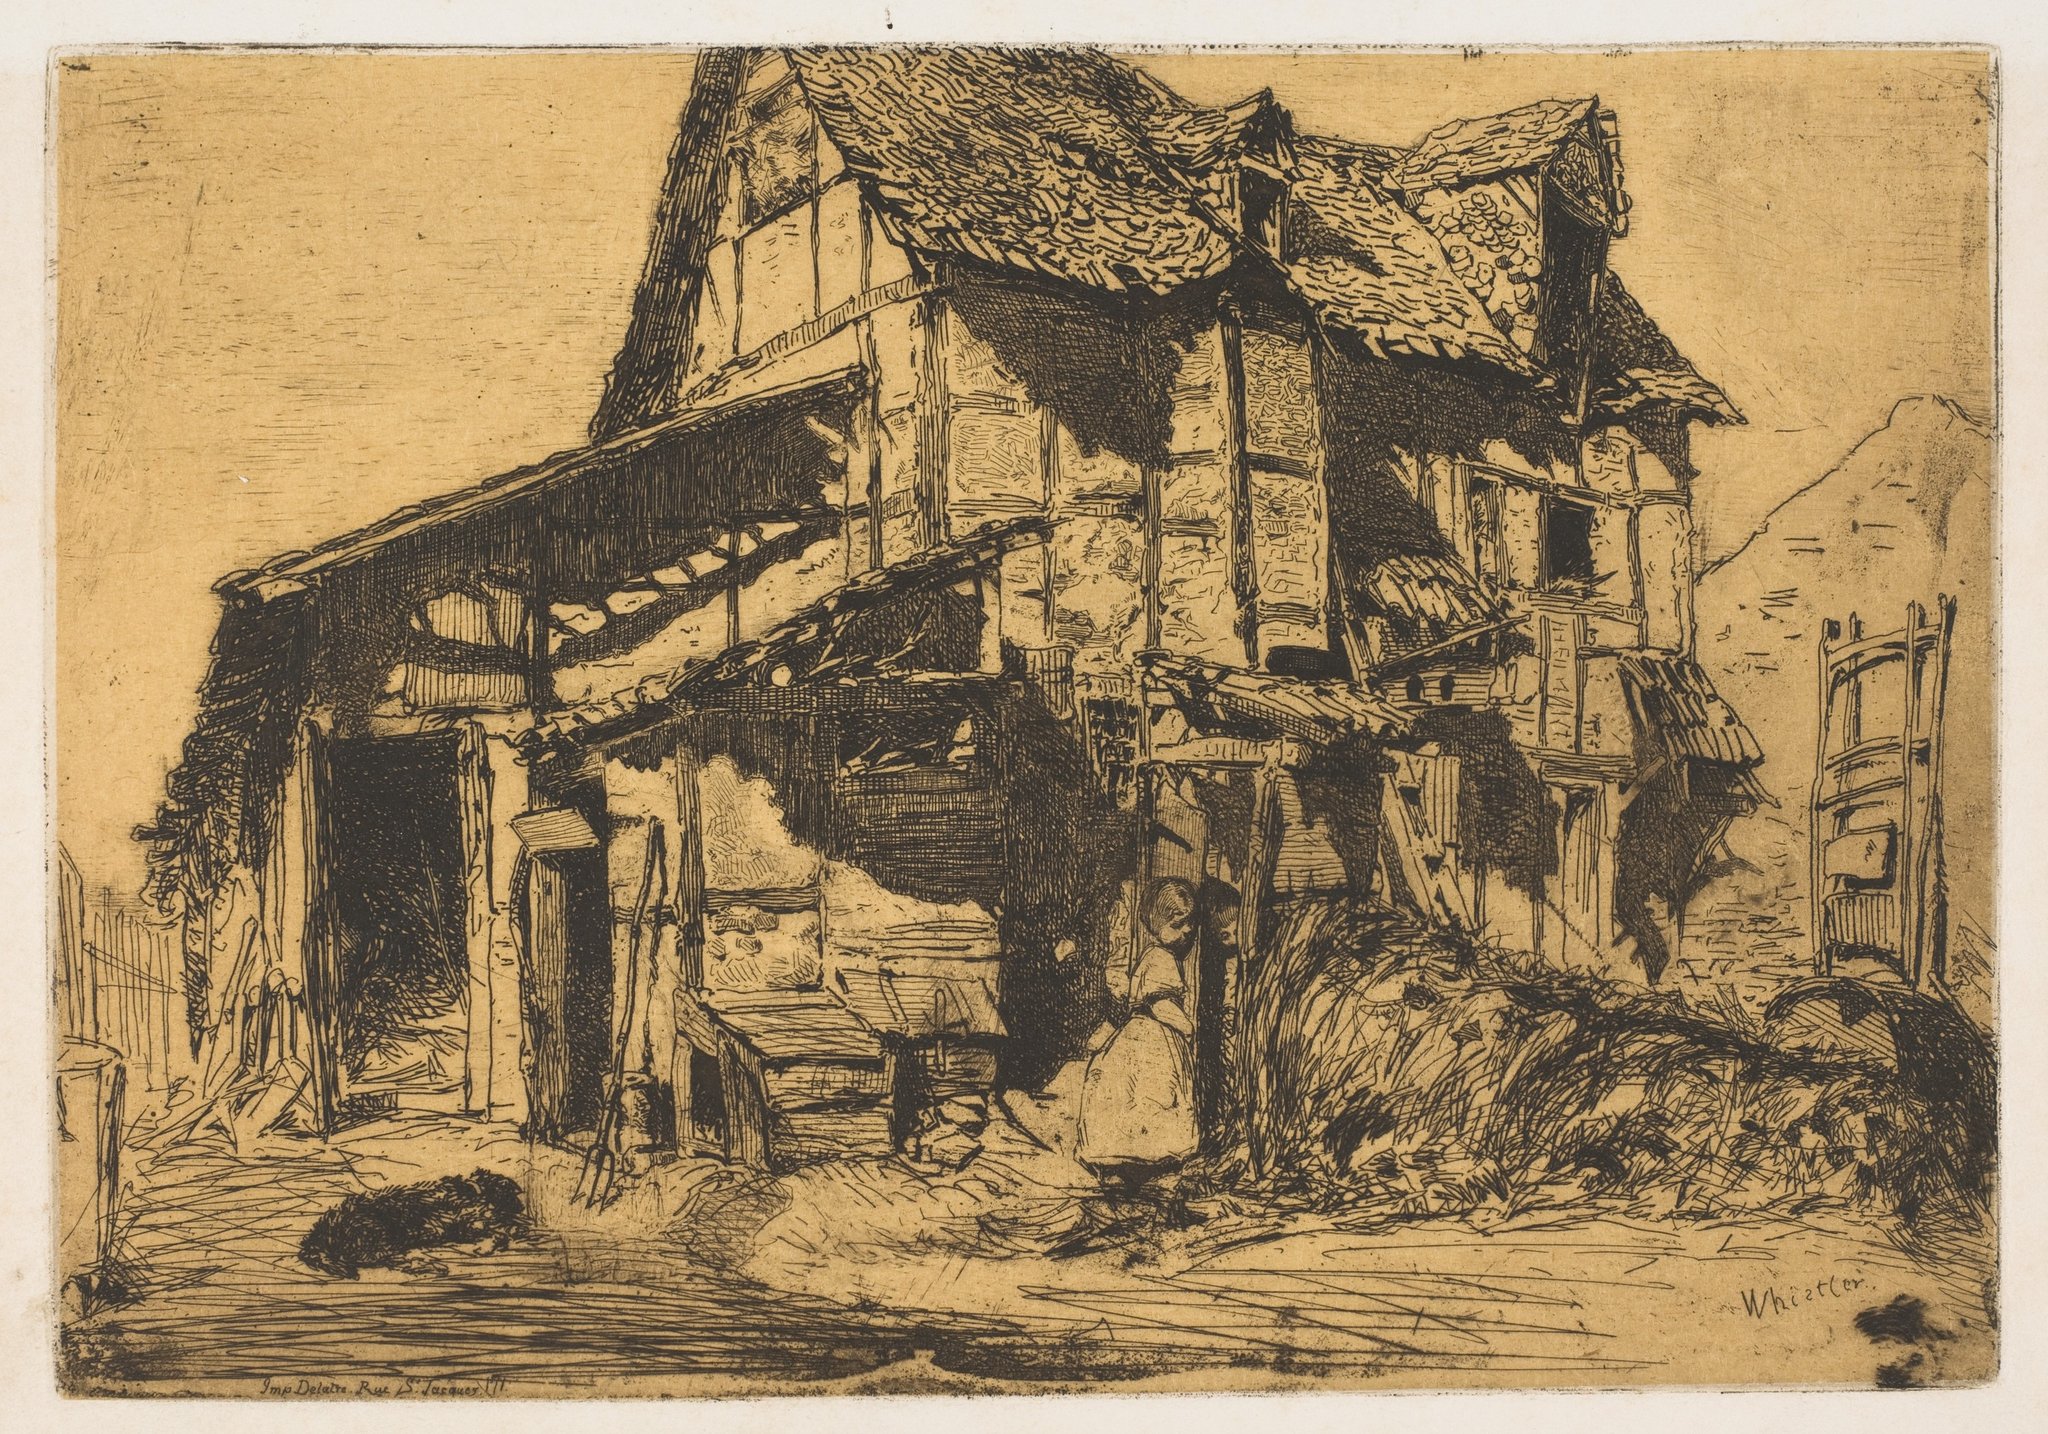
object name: print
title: The Unsafe Tenement (The Old Farm)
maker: james mcneill whistler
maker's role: artist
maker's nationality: american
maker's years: 1834-1903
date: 1858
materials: chine, paper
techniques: printmaking, etching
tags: houses,farms,girls